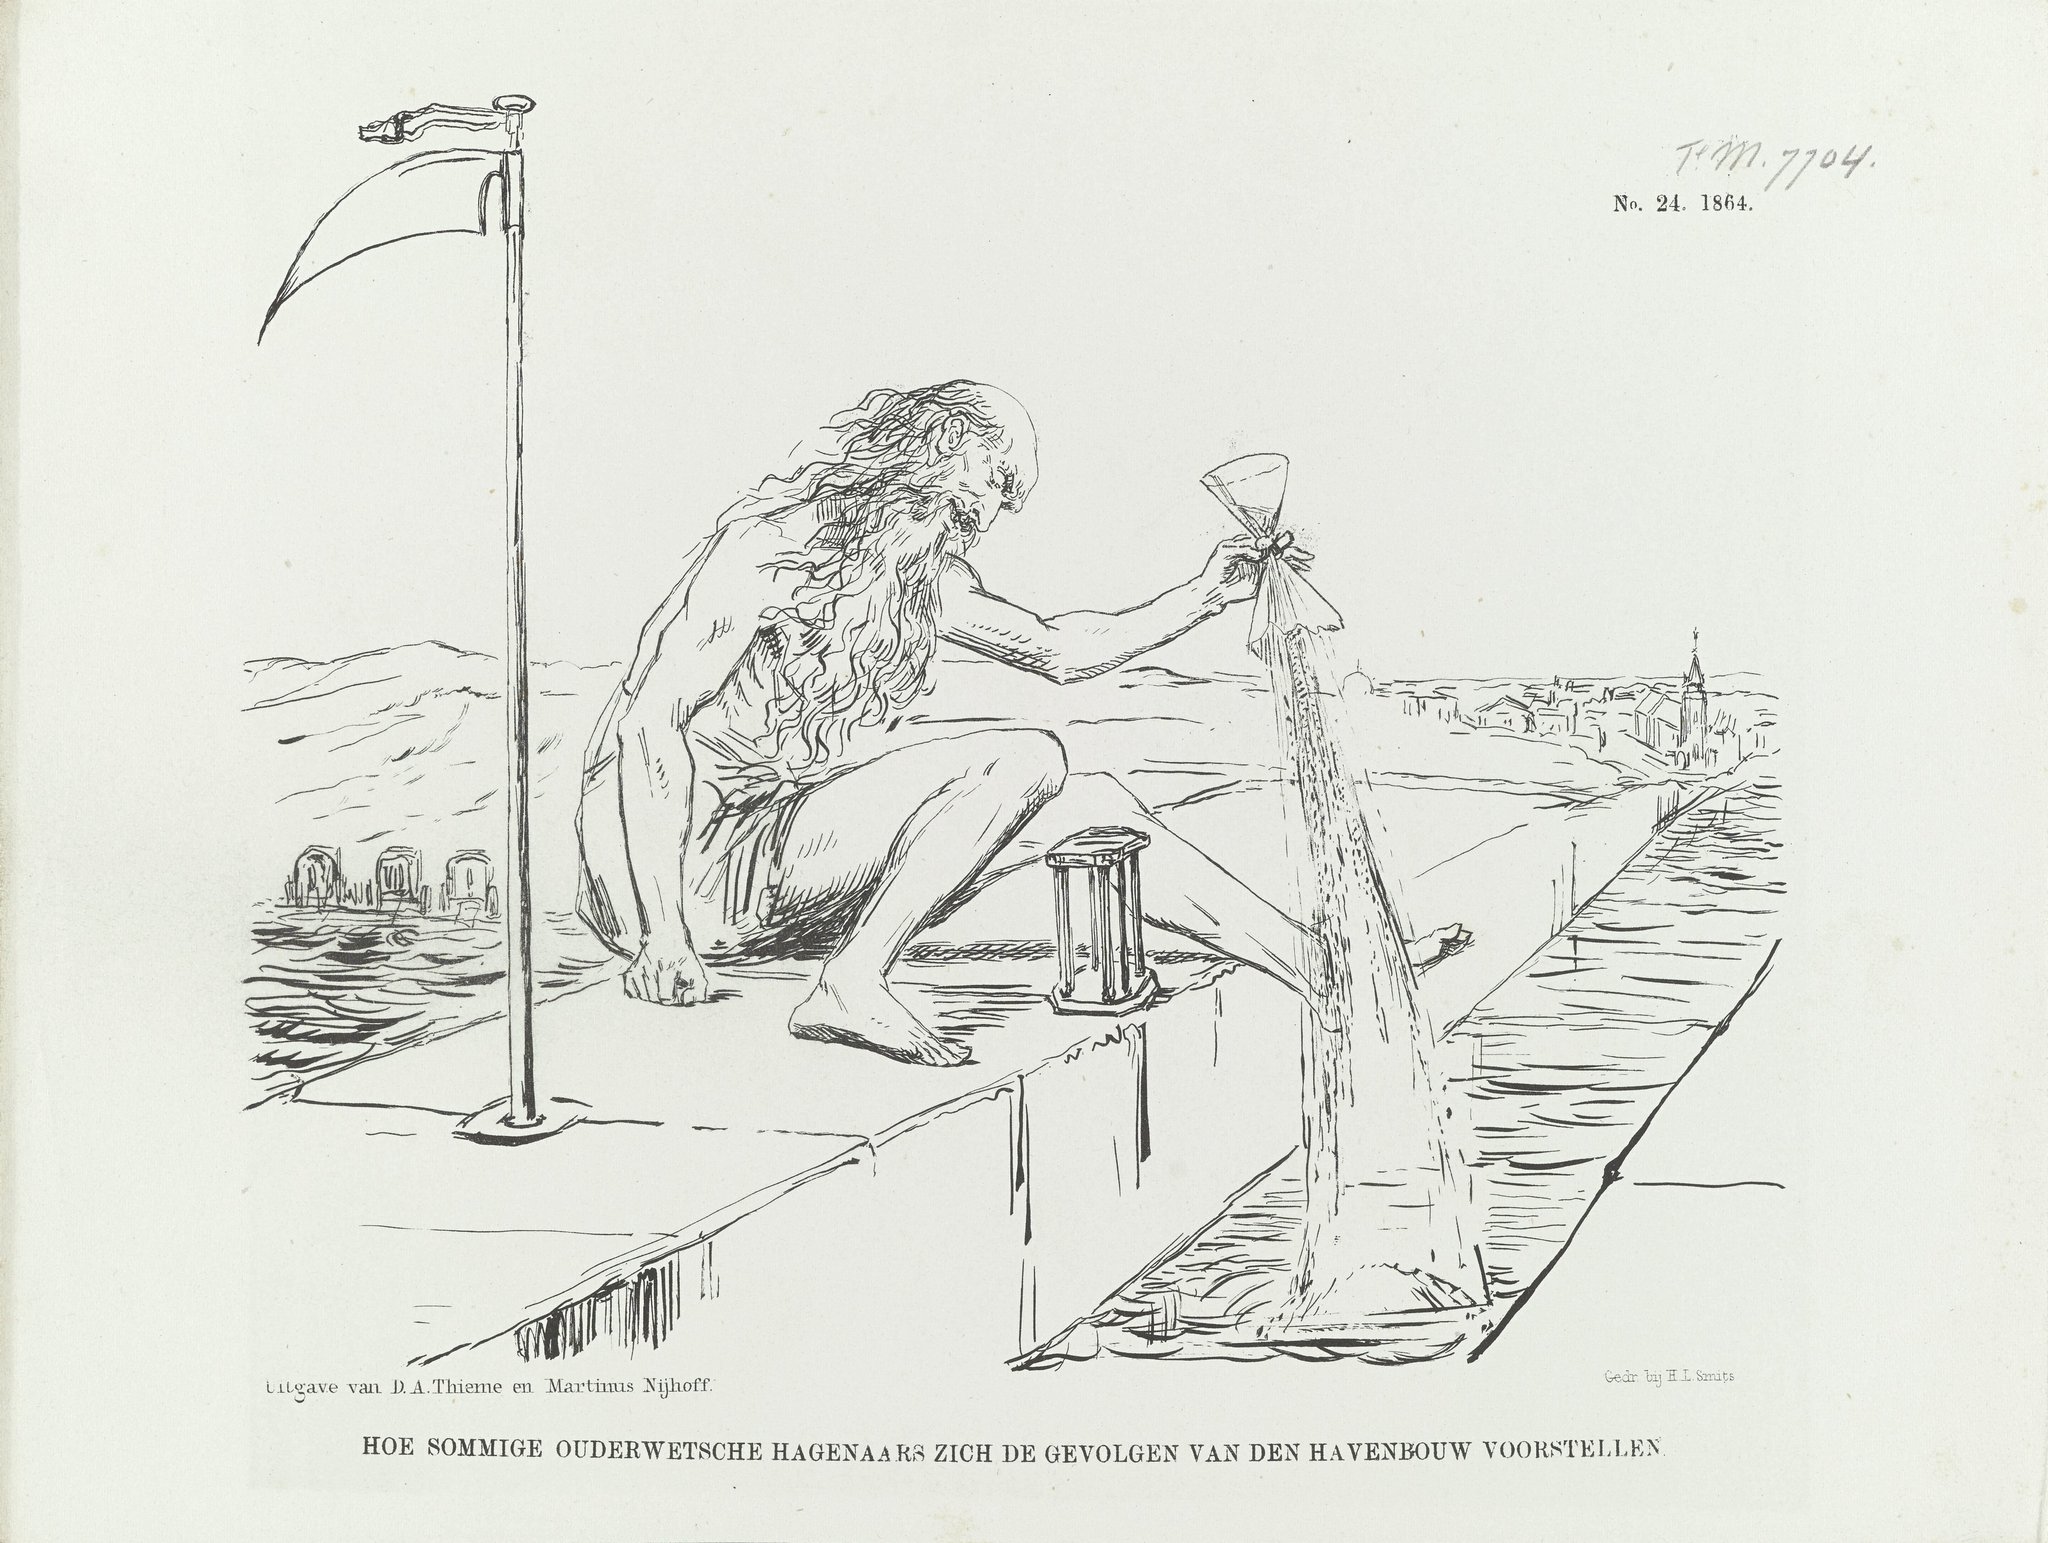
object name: cartoon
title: Spotprent op de plannen voor havenbouw in Den Haag, 1864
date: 1864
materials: paper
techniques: lithograph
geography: arnhem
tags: father time, man with wings and scythe, the hague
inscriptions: collector's mark: Lugt 2228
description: Spotprent op de plannen voor havenbouw in Den Haag. Vader Tijd gooit zijn zandloper leeg in de Scheveningse vaart, naar aanleiding van de angst bij sommigen voor verzanding van de haven. Plaat verschenen bij het weekblad De Nederlandsche Spectator, nr. 24, 11 juni 1864.